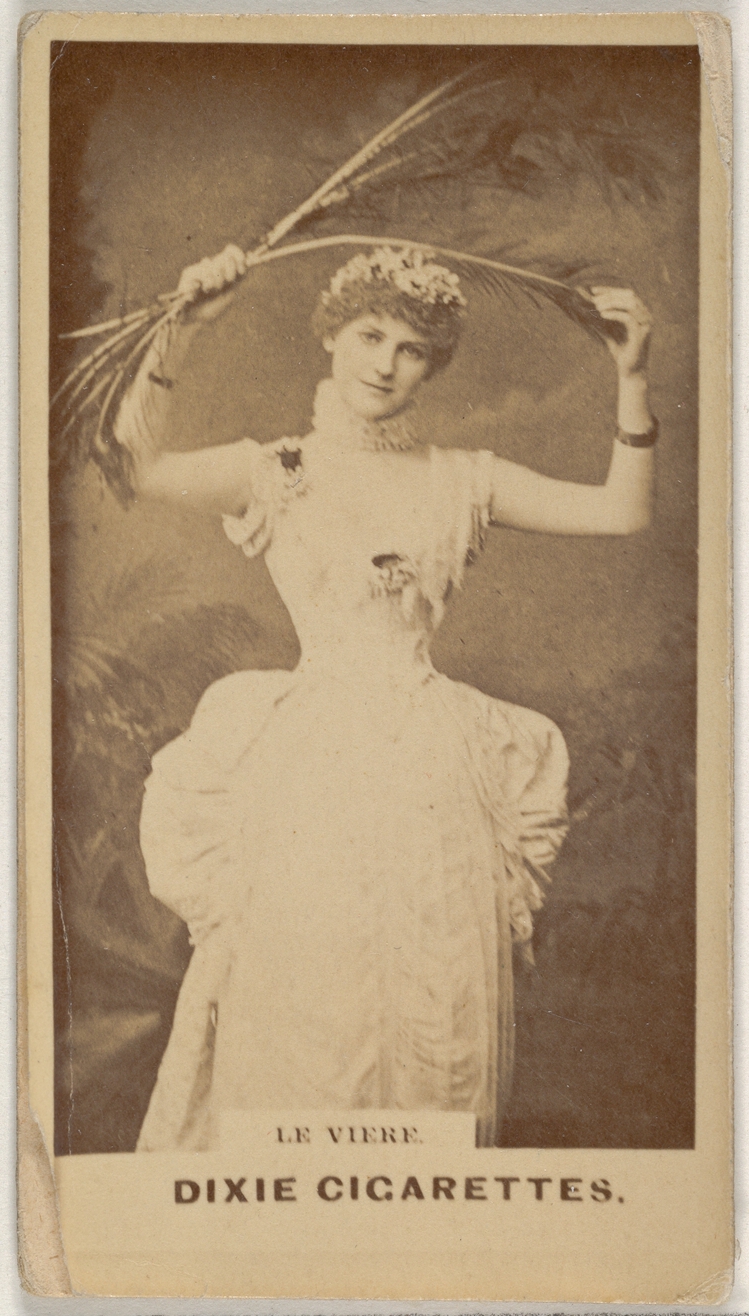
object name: photograph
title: Le Viere, from the Actors and Actresses series (N45, Type 7) for Dixie Cigarettes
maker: allen & ginter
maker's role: publisher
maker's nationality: american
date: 1888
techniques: albumen silver print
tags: portraits,women,actresses